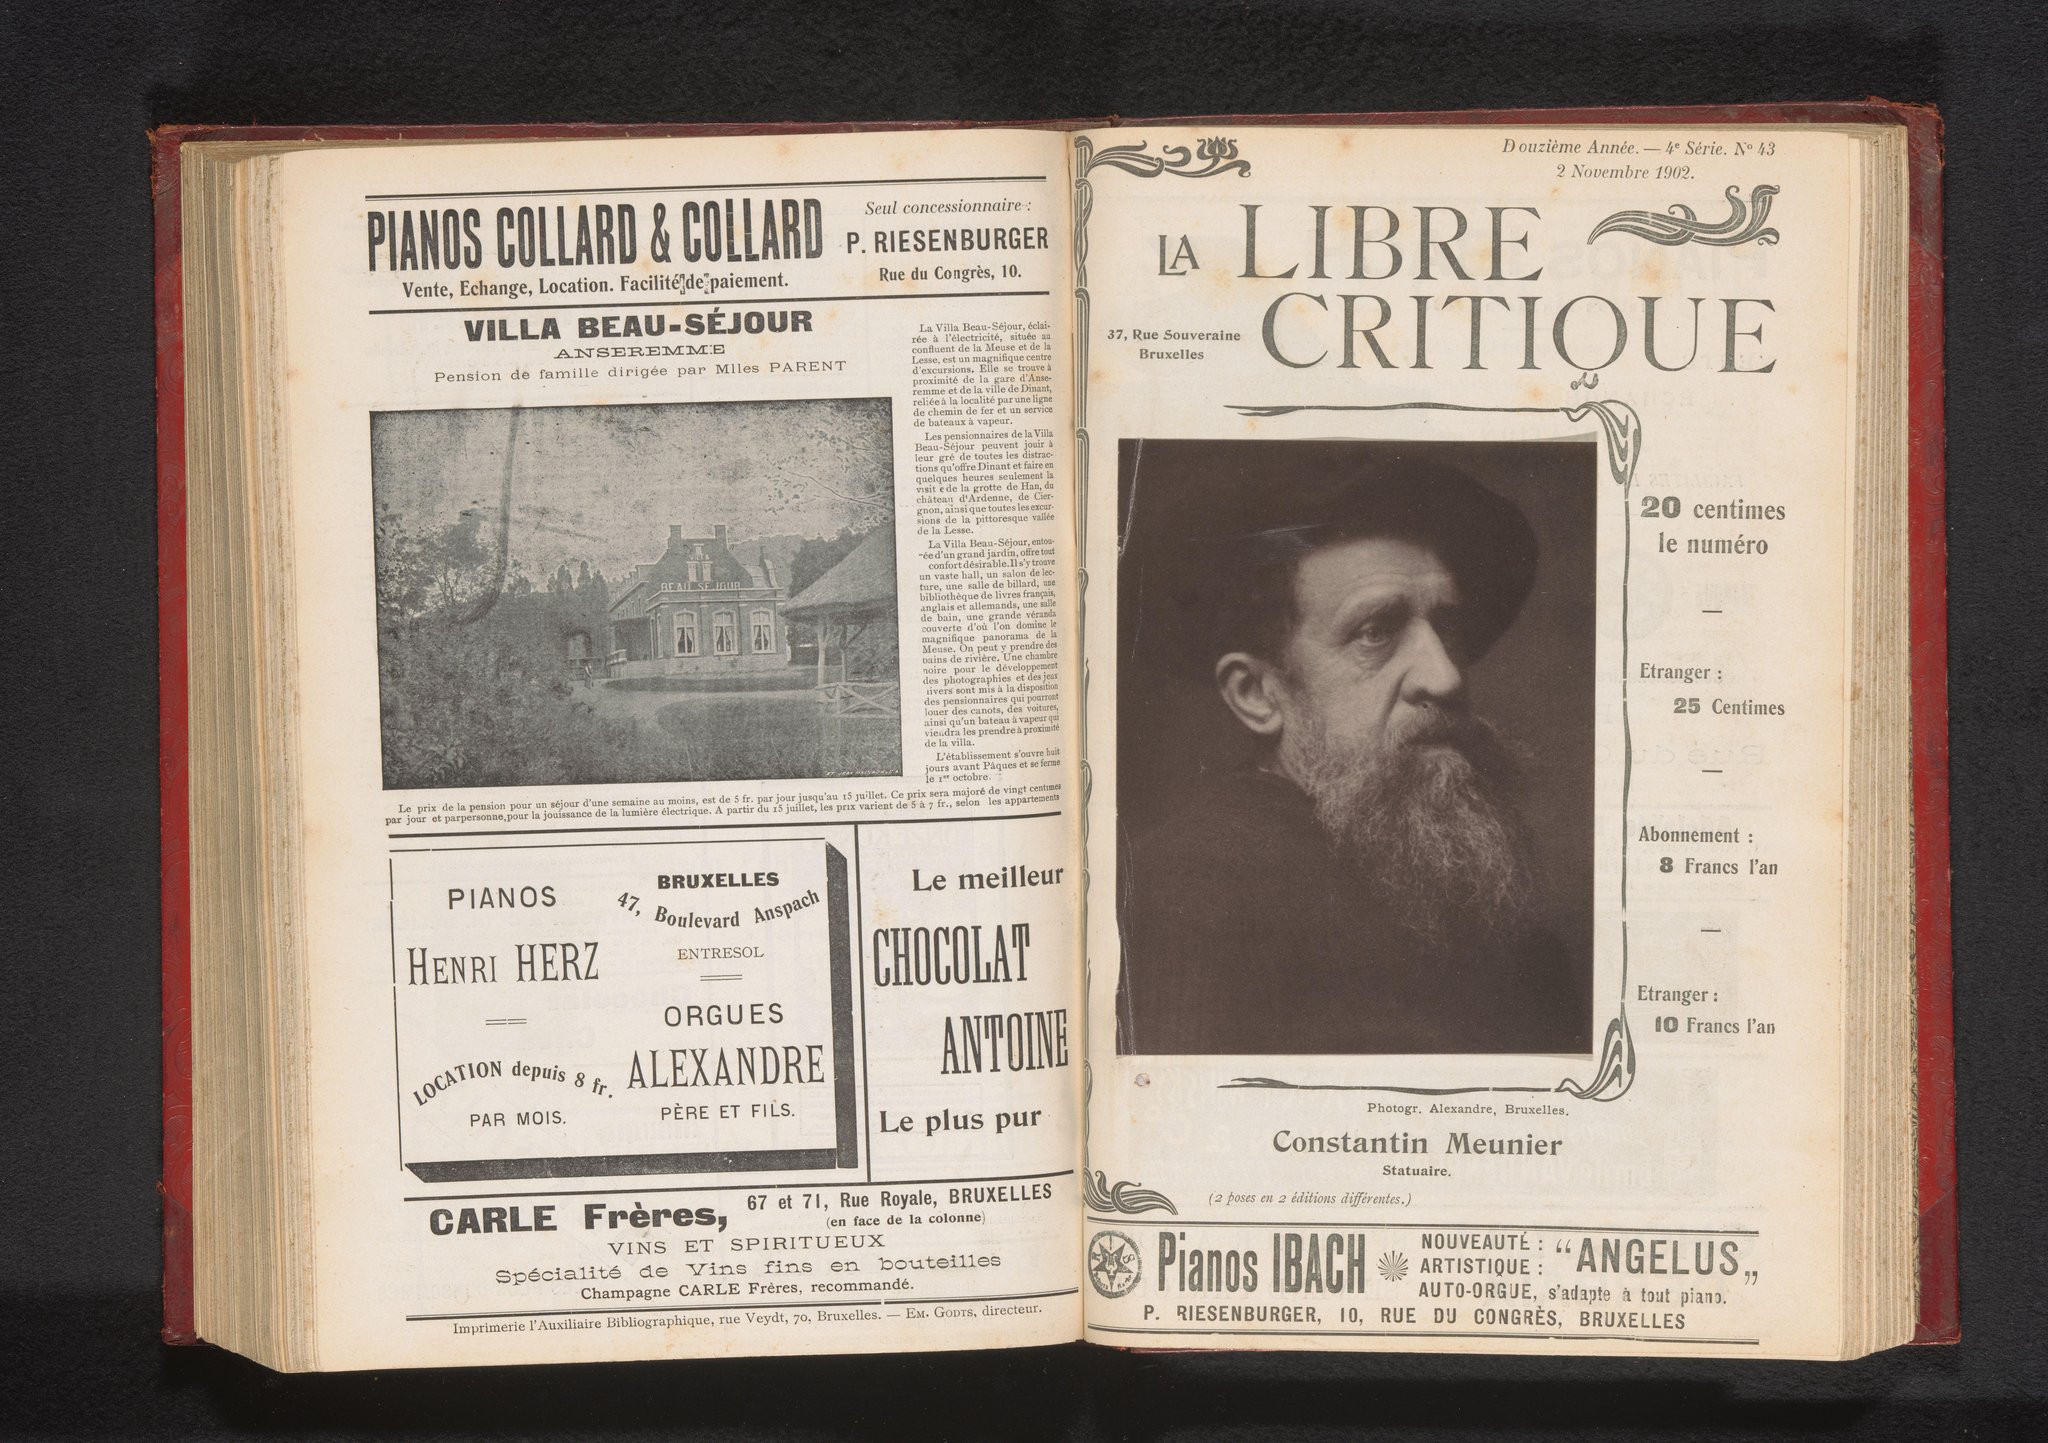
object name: page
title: Portret van Constantin Meunier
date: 1897-1902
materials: paper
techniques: photograph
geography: brussels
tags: constantin emile meunier, portrait, self-portrait of sculptor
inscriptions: inscription: ‘Statuaire’